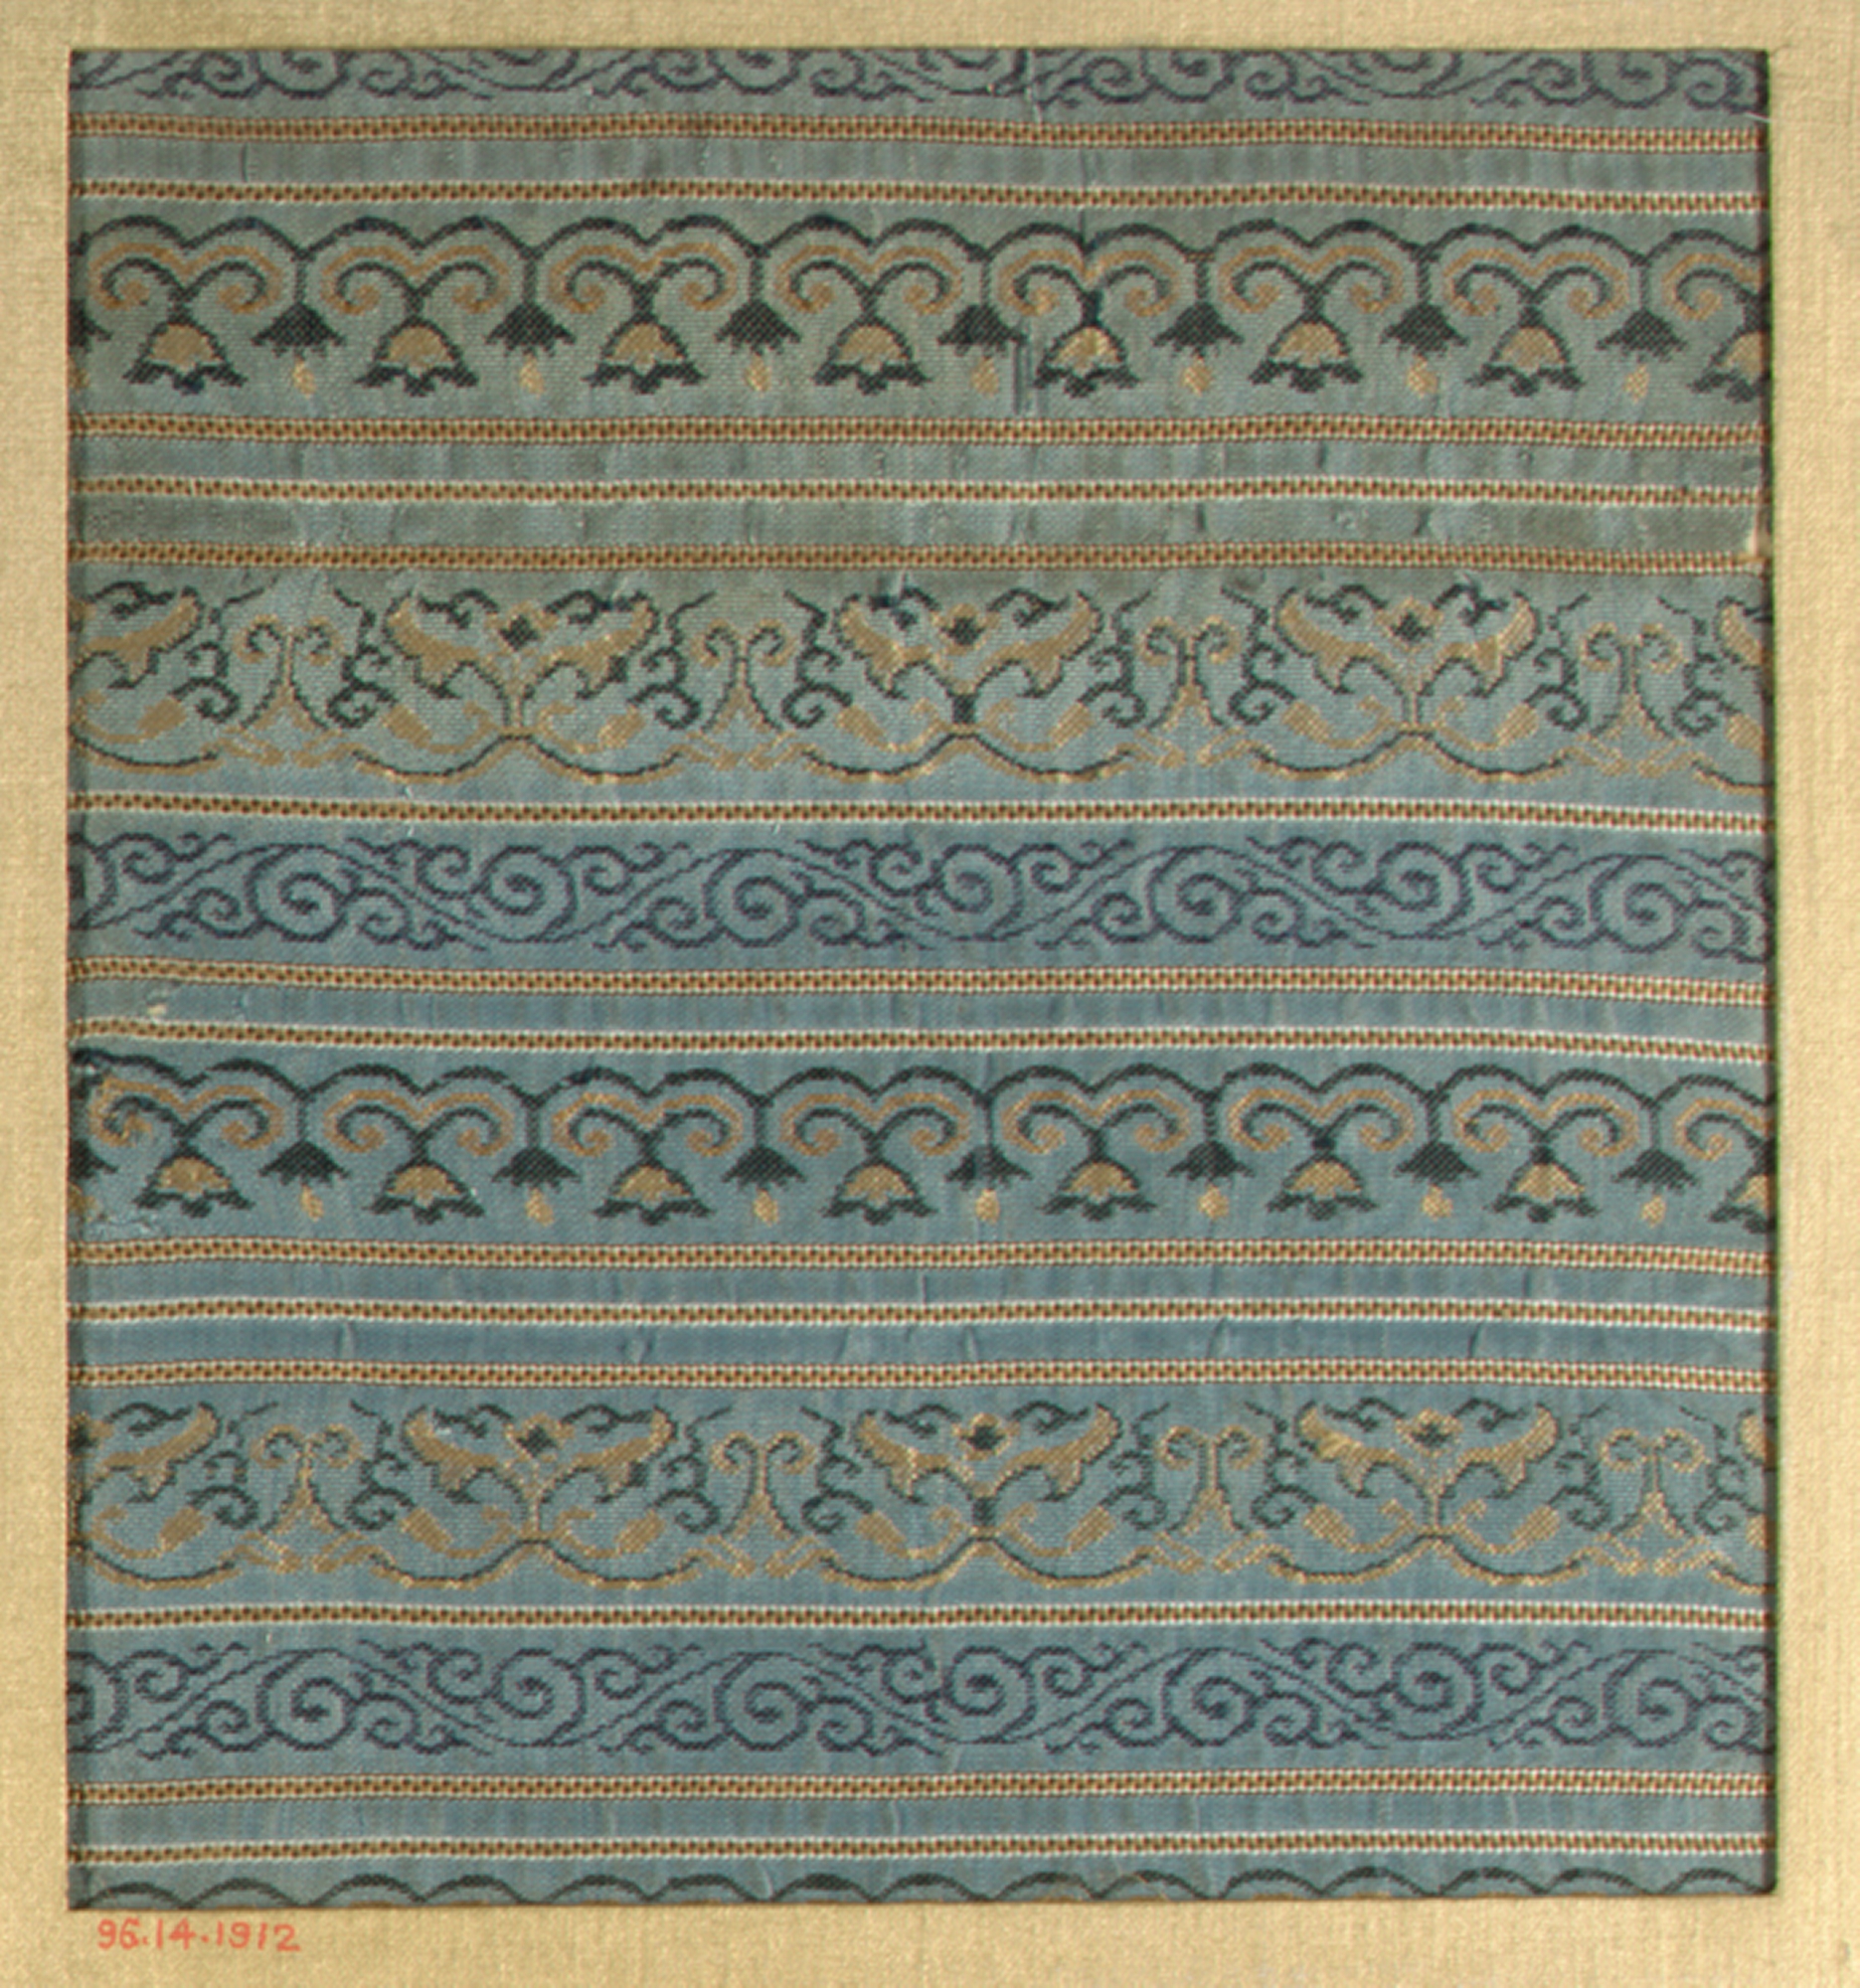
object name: piece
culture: japanese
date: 1701-1900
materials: silk